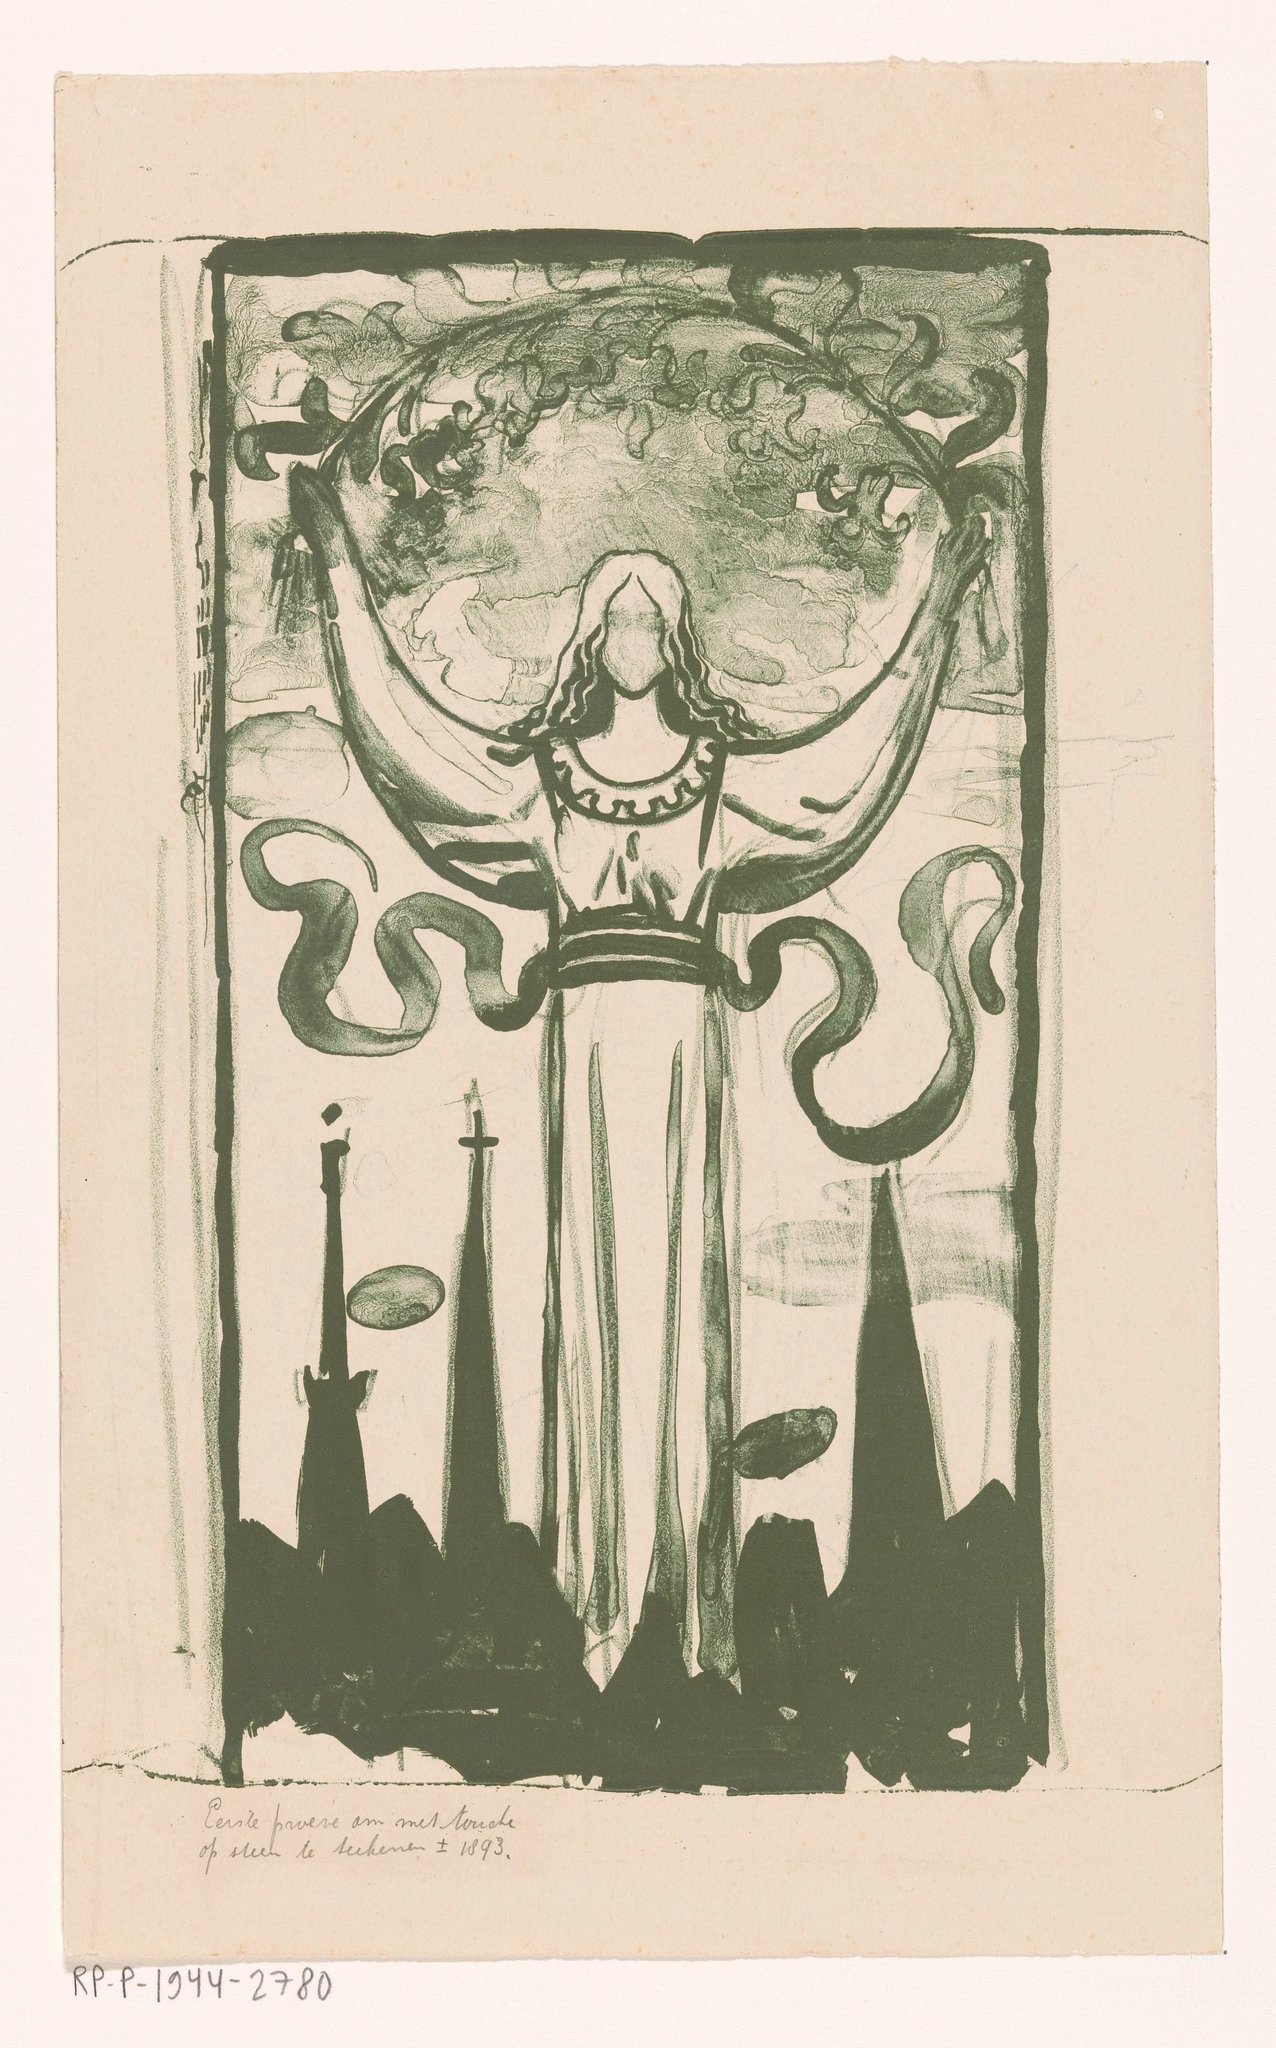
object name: print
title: Vrouwenfiguur die een tak met bloemen boven haar hoofd houdt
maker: antoon derkinderen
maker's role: draughtsman, painter, print maker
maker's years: 1859-1925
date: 1893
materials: paper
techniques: lithograph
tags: flowers, standing figure - aa - female human figure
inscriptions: collector's mark: Lugt 2228, : ‘Eerste proeve om met touche op steen te teekenen +/- 1893’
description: Naast de vrouw de silhouetten van kerktorens. Op verso een proefdruk van een advertentie voor het boek 'Vóór de Hervorming' van Pieter Vergers.